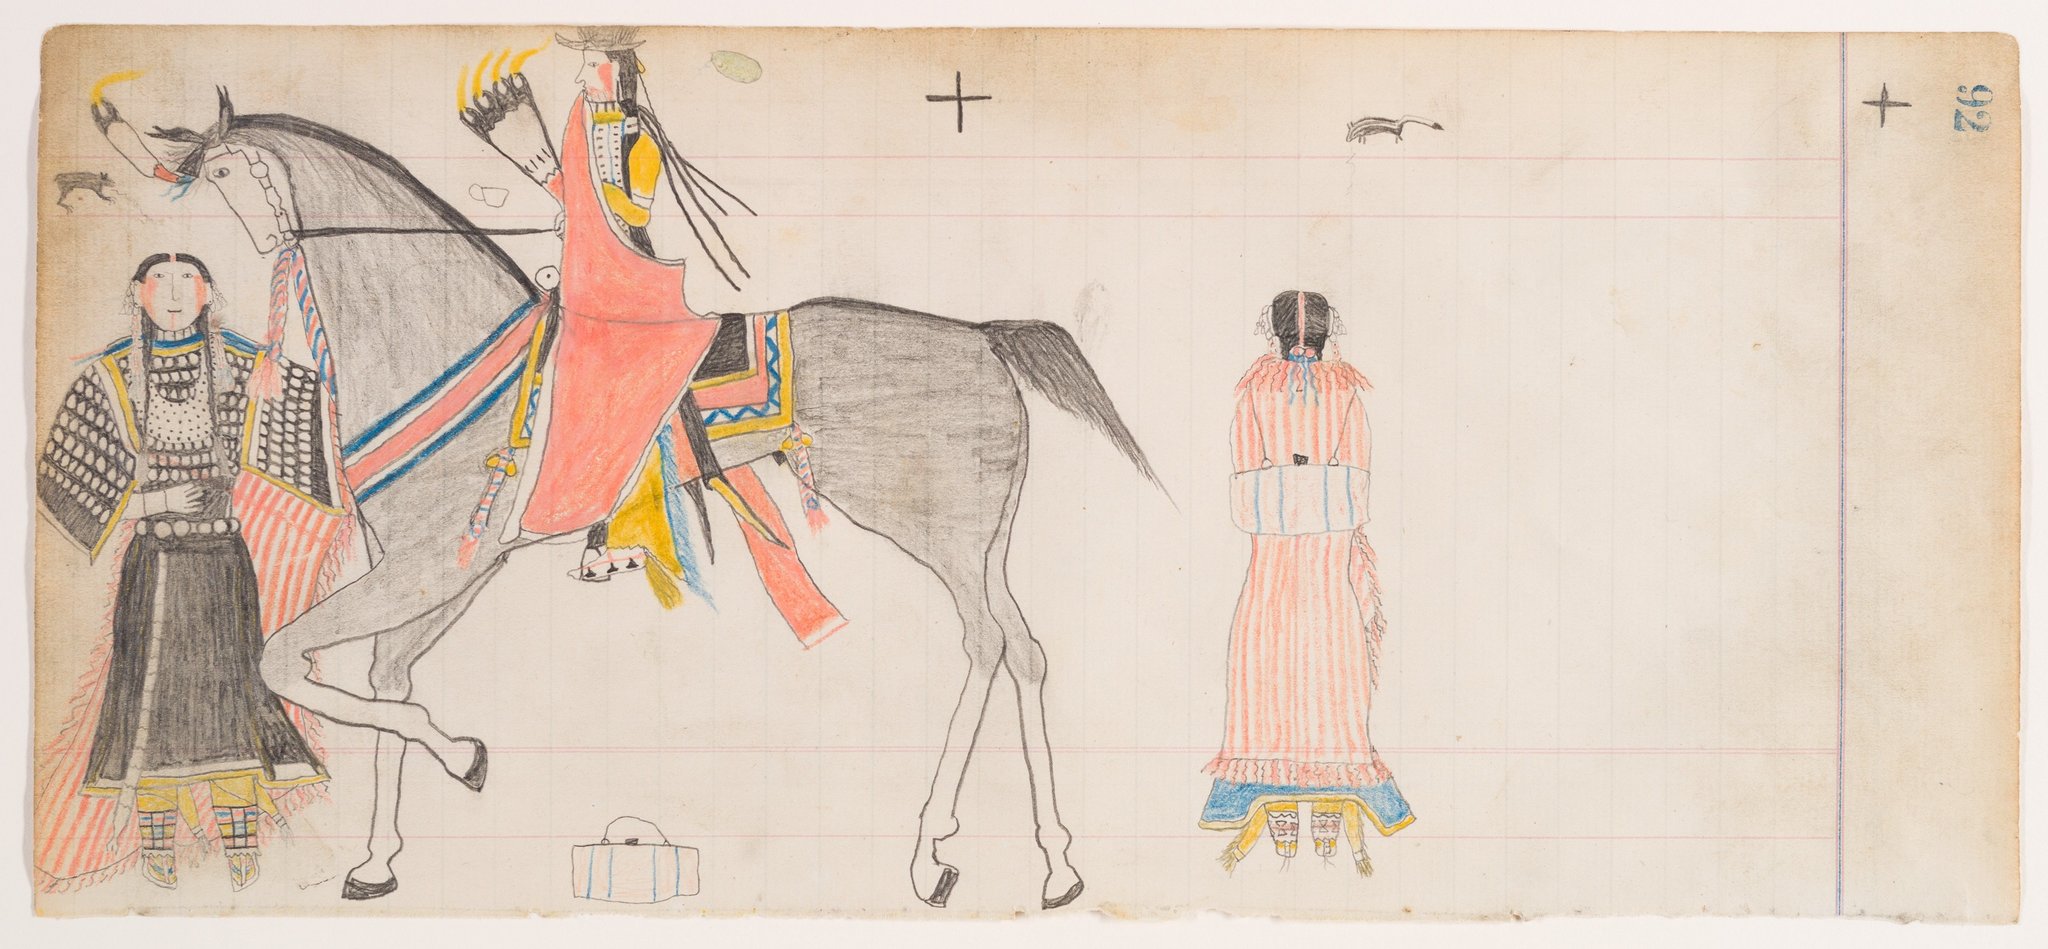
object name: drawing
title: Man and Two Women (Henderson Ledger Artist B)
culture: arapaho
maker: frank henderson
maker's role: artist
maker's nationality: native american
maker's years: 1862-1885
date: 1882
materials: ink, paper, pencil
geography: united states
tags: men,women,horses